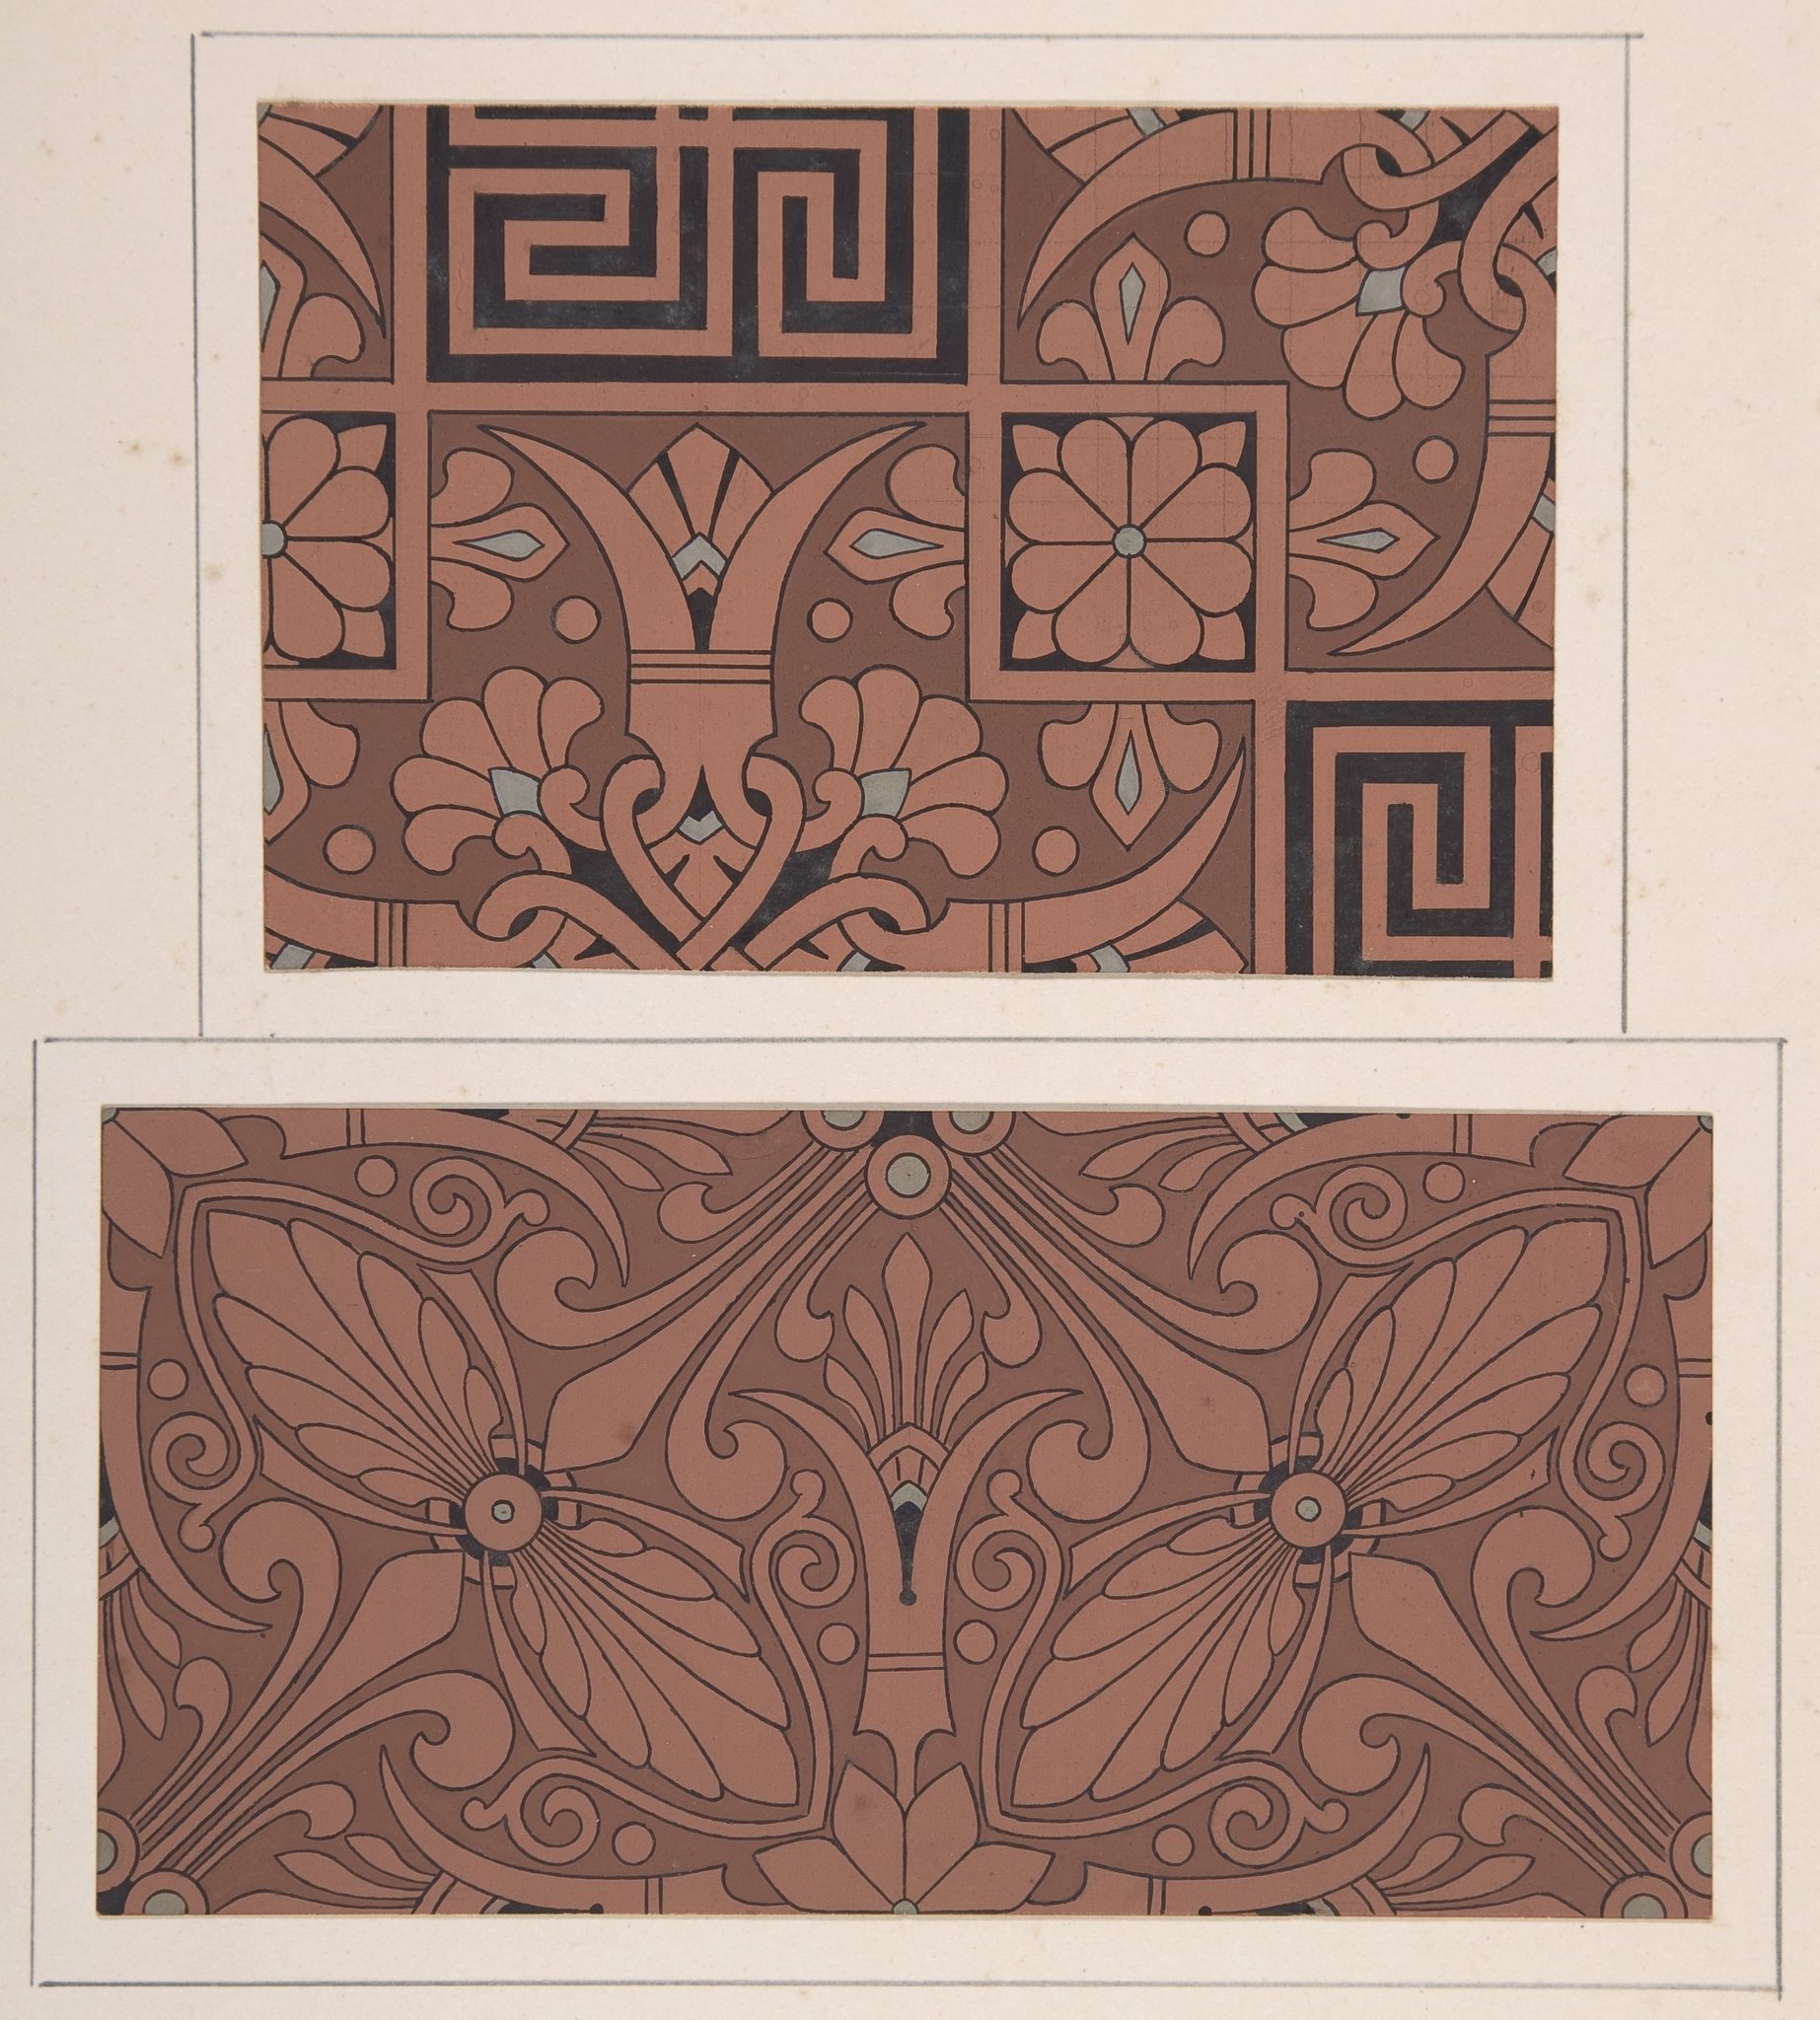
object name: drawing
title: Design drawing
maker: christopher dresser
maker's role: designer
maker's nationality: british, scottish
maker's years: 1834-1904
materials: gouache, graphite, ink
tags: ornament